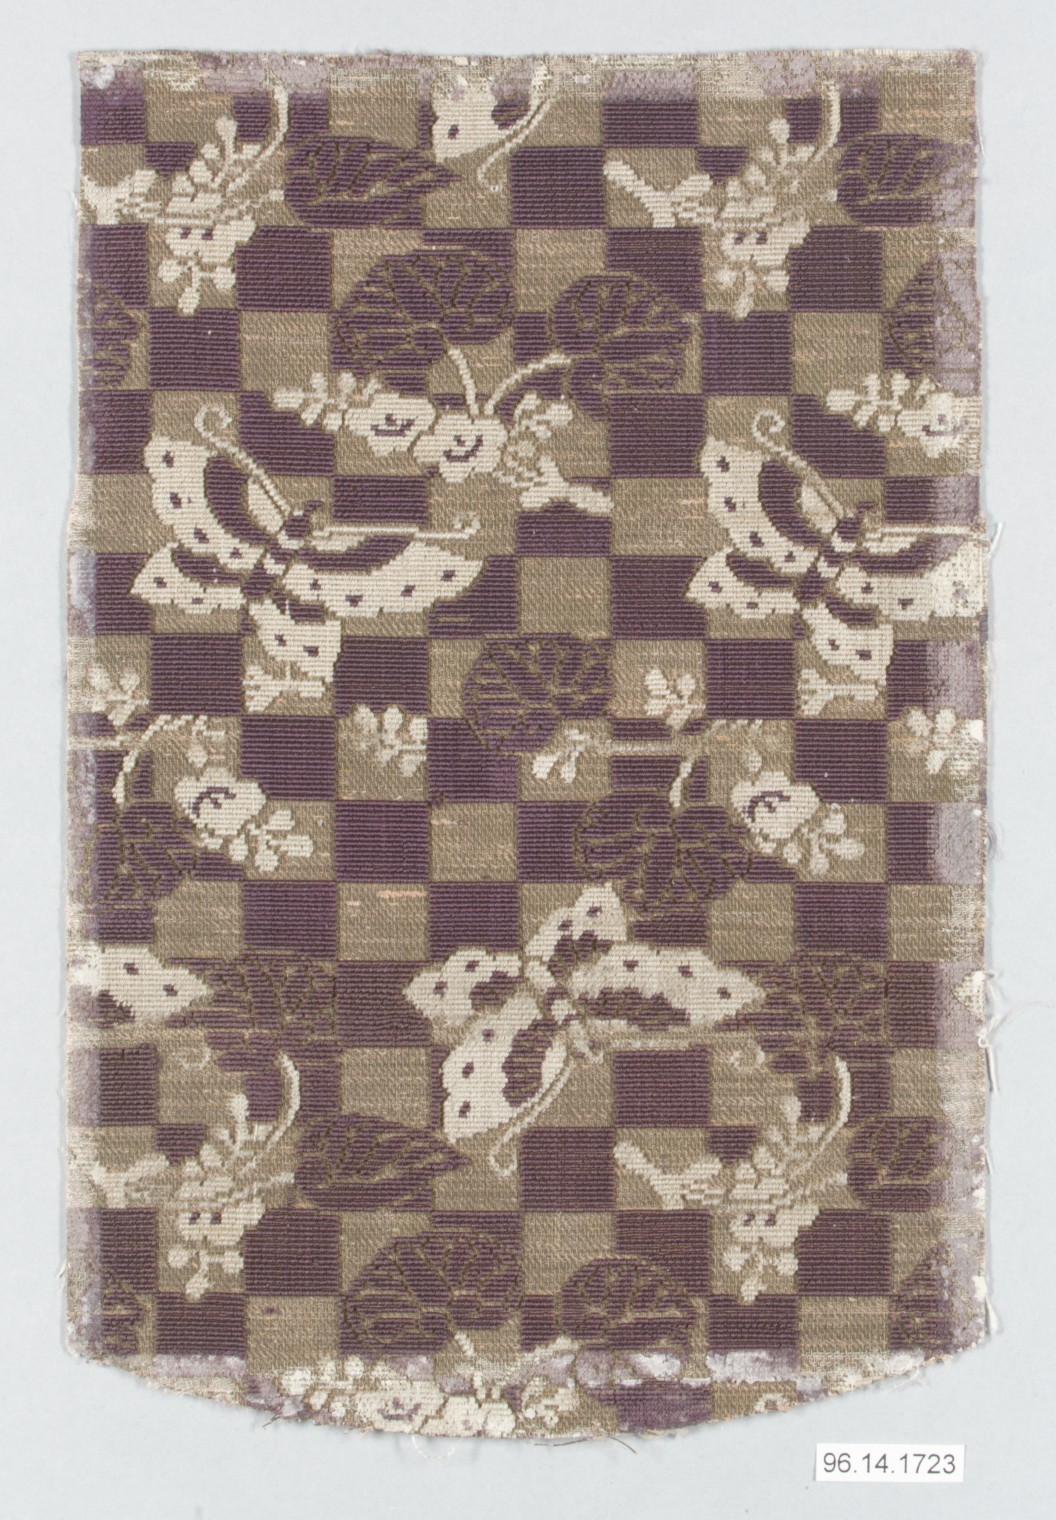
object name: piece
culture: japanese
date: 1701-1900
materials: silk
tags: butterflies